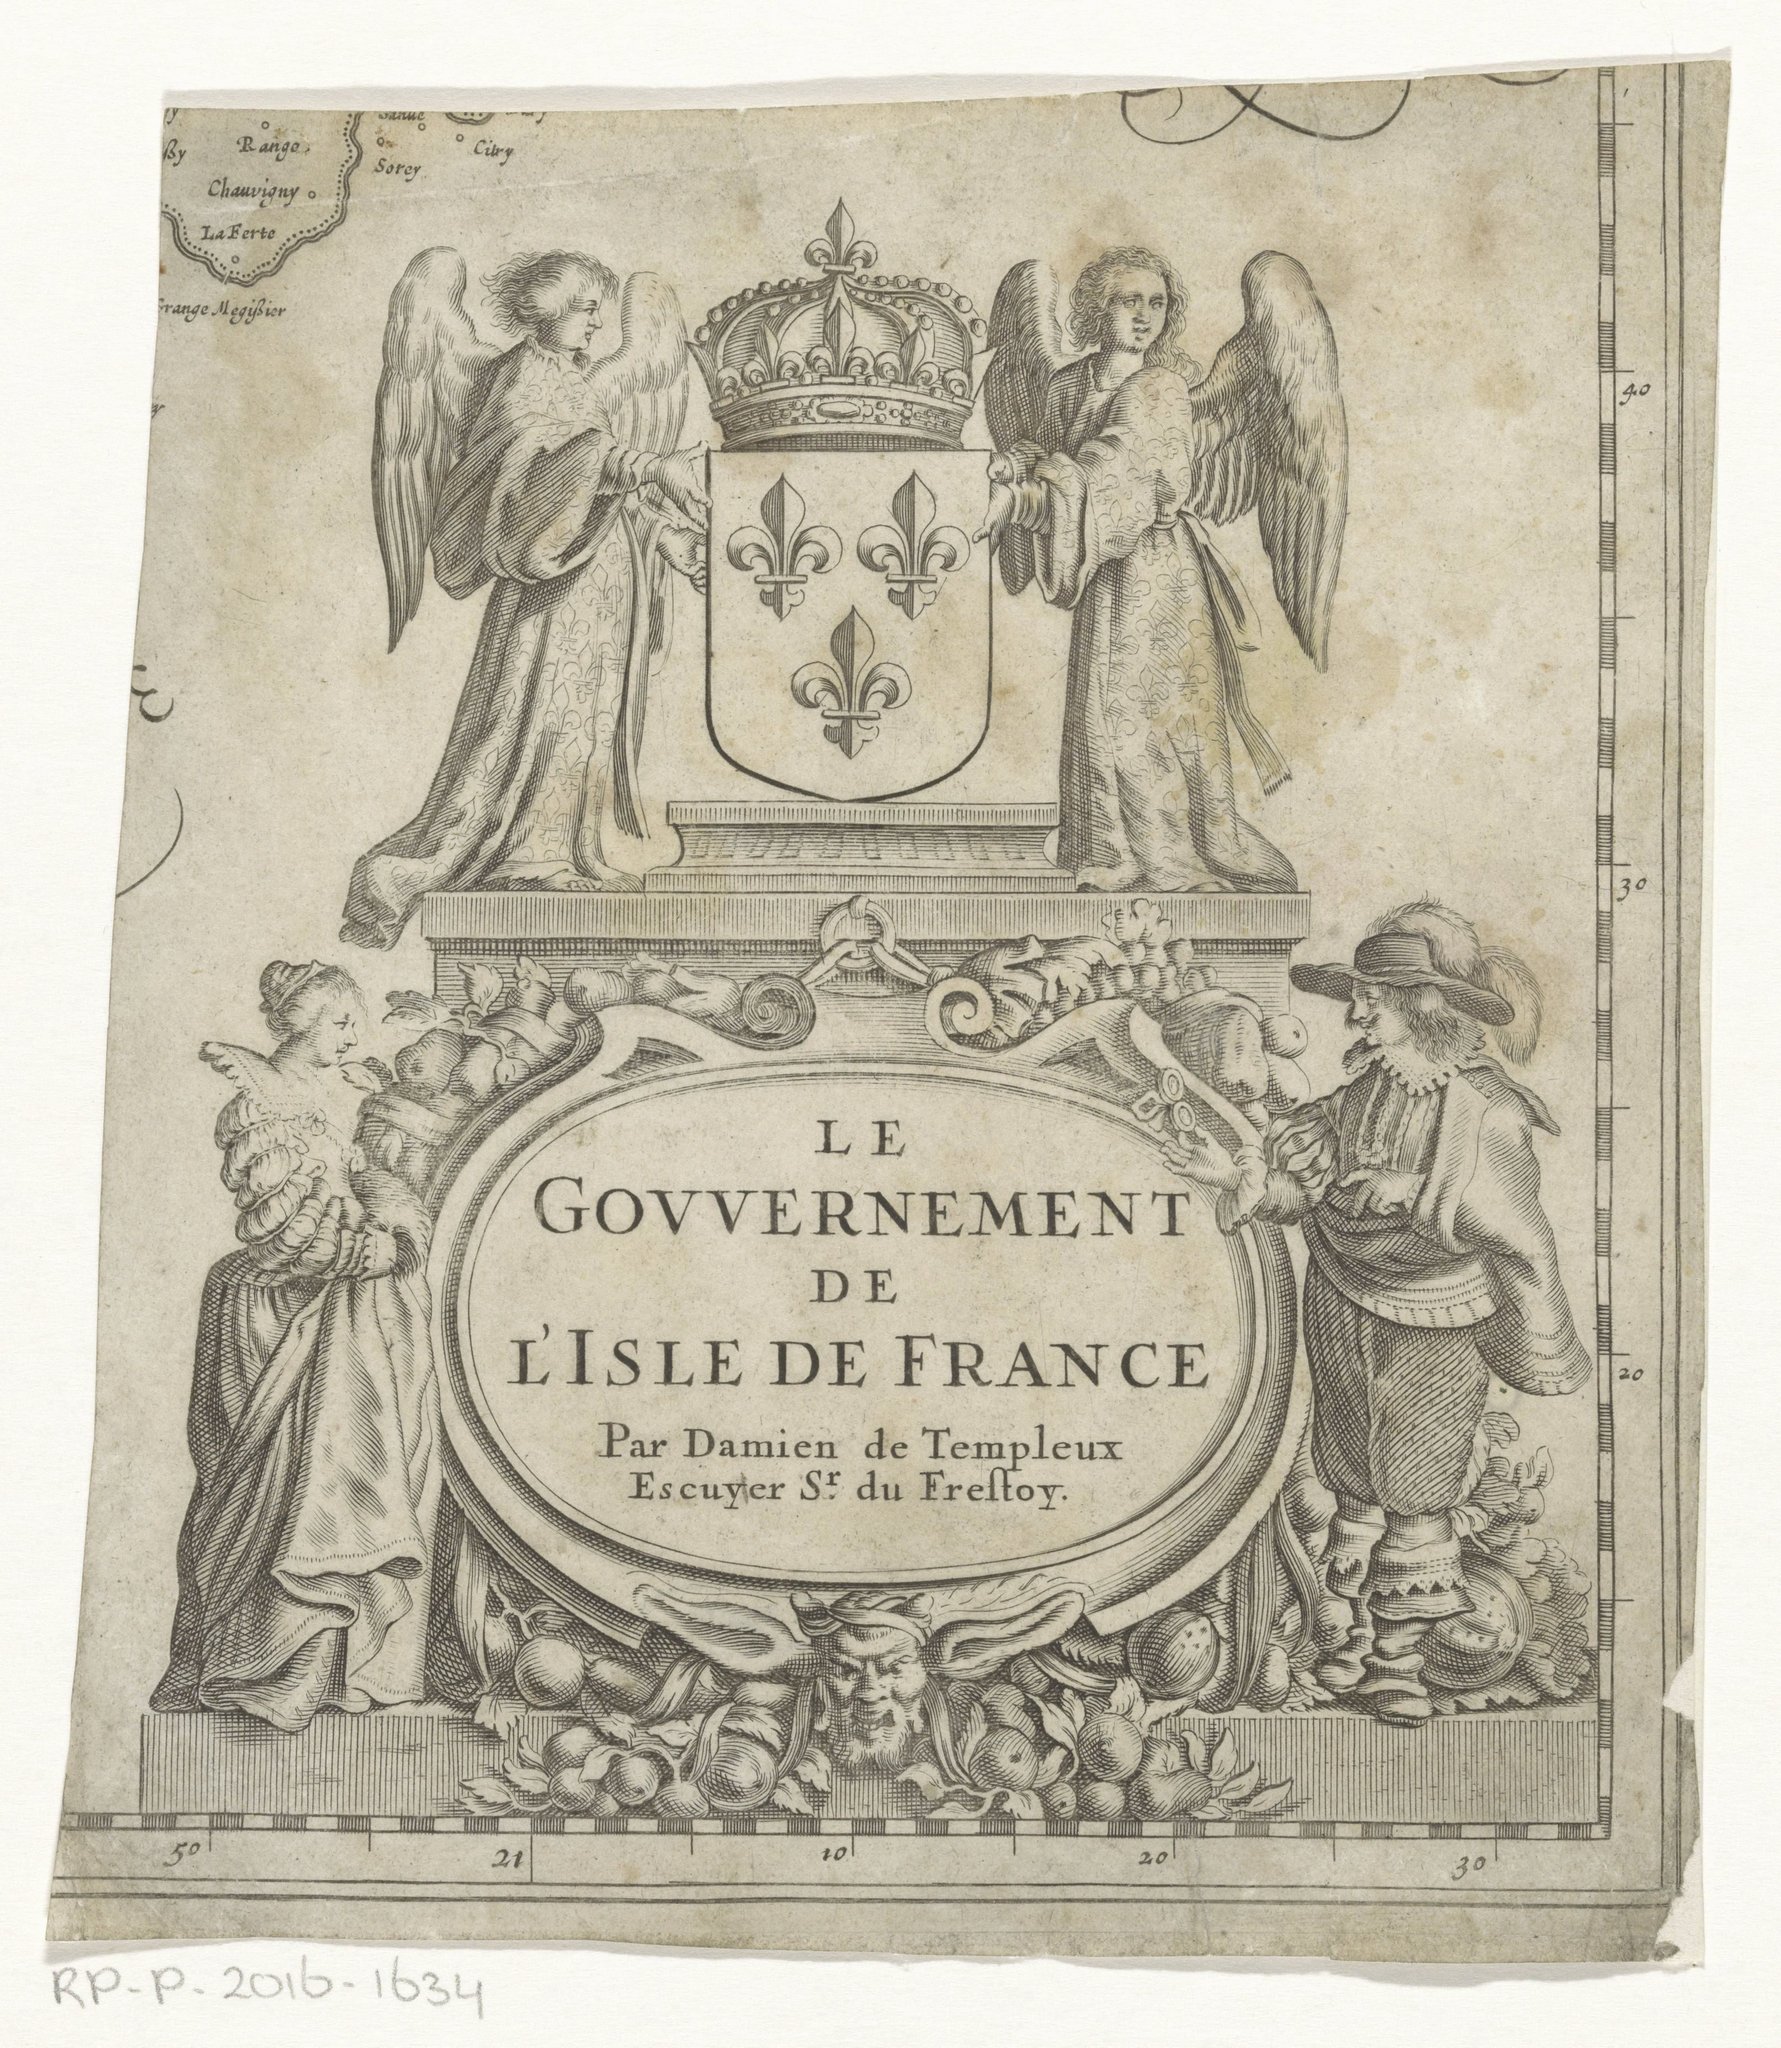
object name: print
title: man, vrouw en engelen met wapen van Frankrijk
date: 1634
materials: paper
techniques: engraving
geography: amsterdam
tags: coat of arms (as symbol of the state, etc.), ornament ~ cartouche, angels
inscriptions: collector's mark: Lugt 2228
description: Een man en vrouw flankeren een cartouche met titel en fruit. Daarboven staan twee engelen met het gekroonde wapen van Frankrijk. Detail van een kaart van Ile-de-France.